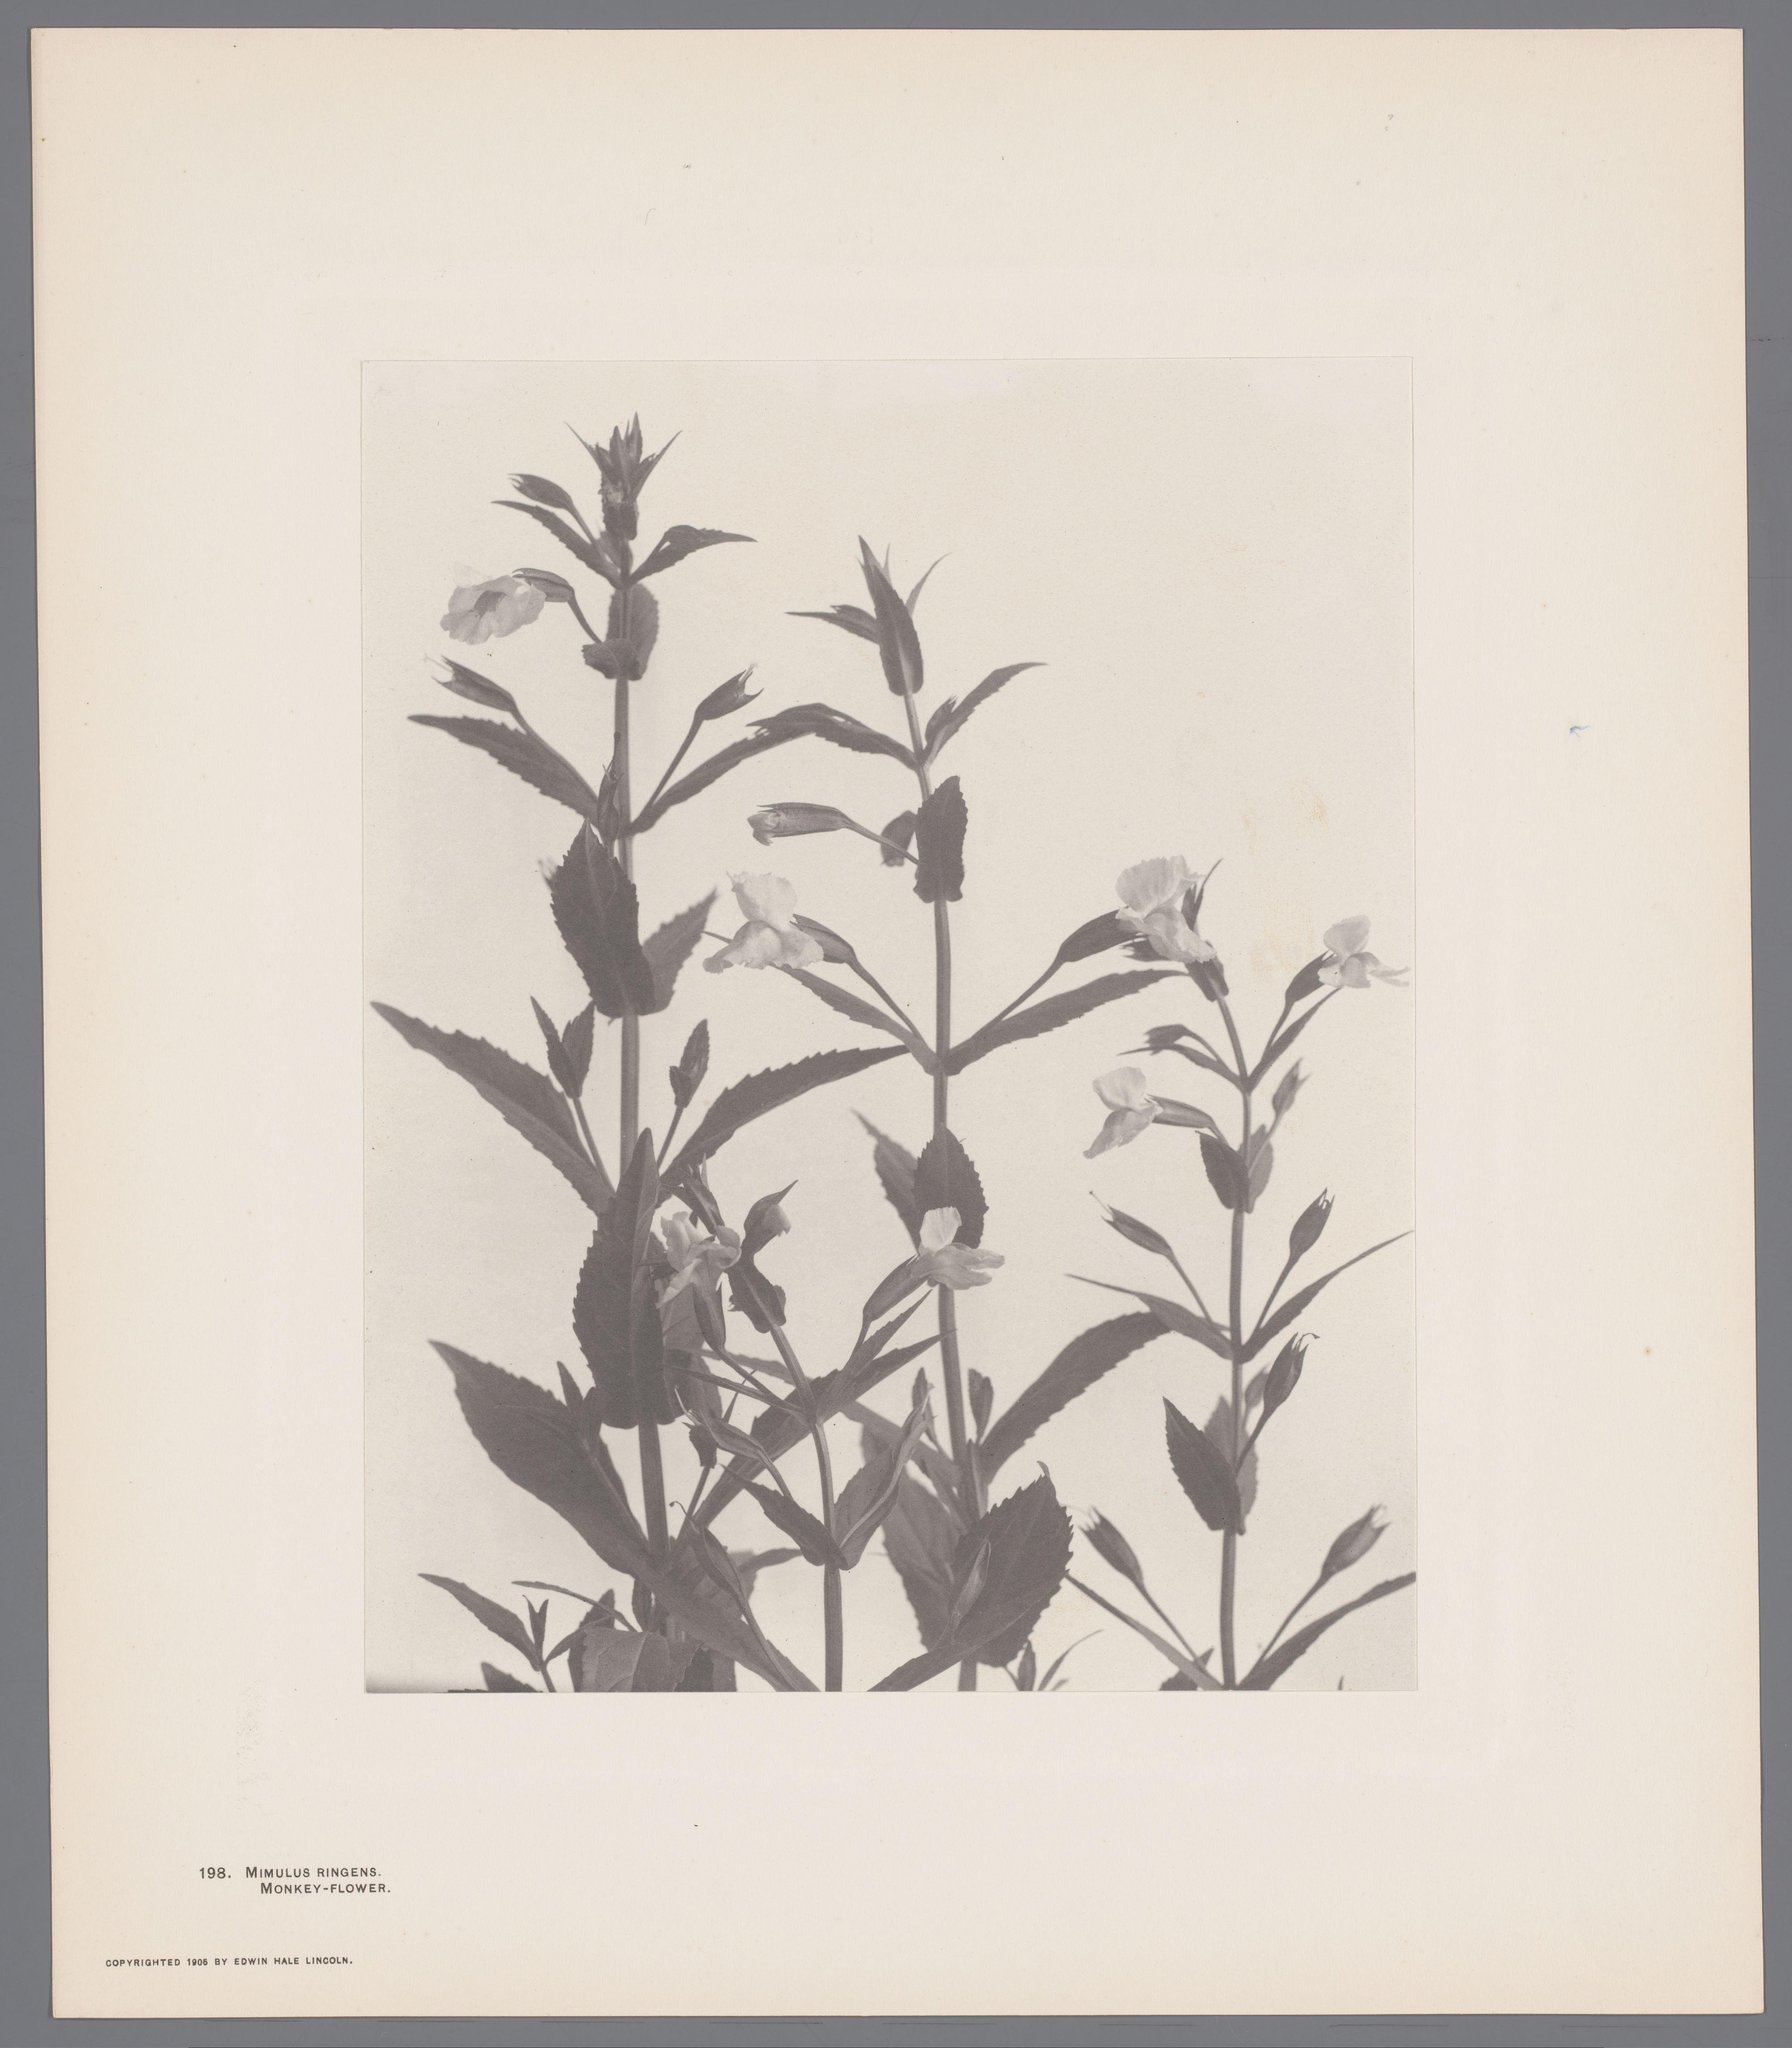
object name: photograph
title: Foto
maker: edwin hale lincoln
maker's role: fotograaf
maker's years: 1848-1938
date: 1905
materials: paper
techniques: photography